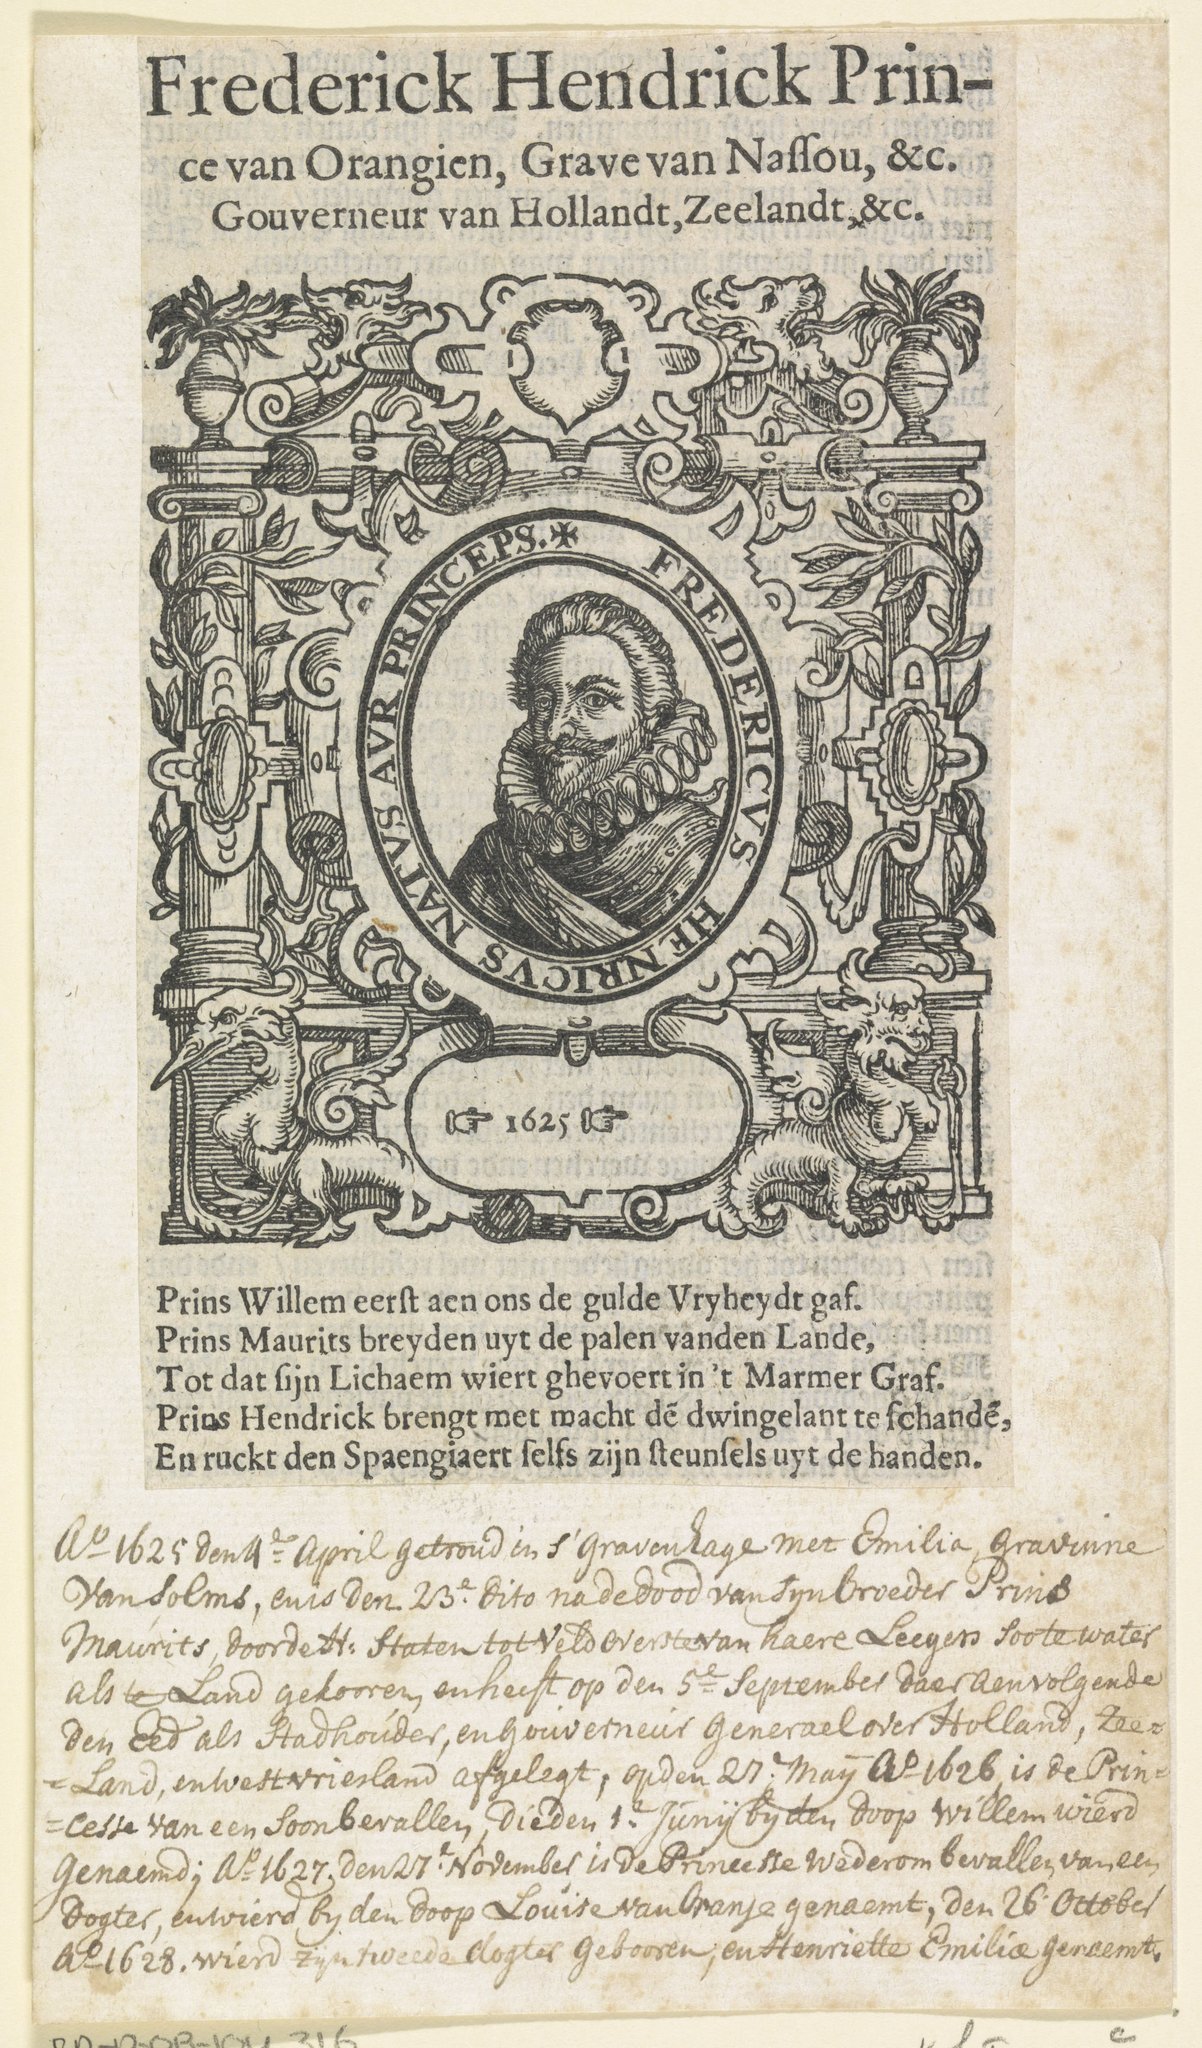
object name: book illustration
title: Portret van Frederik Hendrik, prins van Oranje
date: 1606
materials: paper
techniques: letterpress printing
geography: low countries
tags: delft, the hague, frederick henry (prince of orange)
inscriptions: collector's mark: Lugt 963, inscription: ‘Ao 1625 den 4e April getroud ... Henriette Emilia genaemt.’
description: De hier vermelde titel verwijst naar de hoogst verkregen titel van de geportretteerde, niet per se naar de titel die de geportretteerde op deze voorstelling draagt. Prent uit: Grammaticus, Saxo (pseudoniem van Petrus Scriverius). Oudt Batavien nu ghenaemt Holland. Leiden: Andries Clouck, 1606.